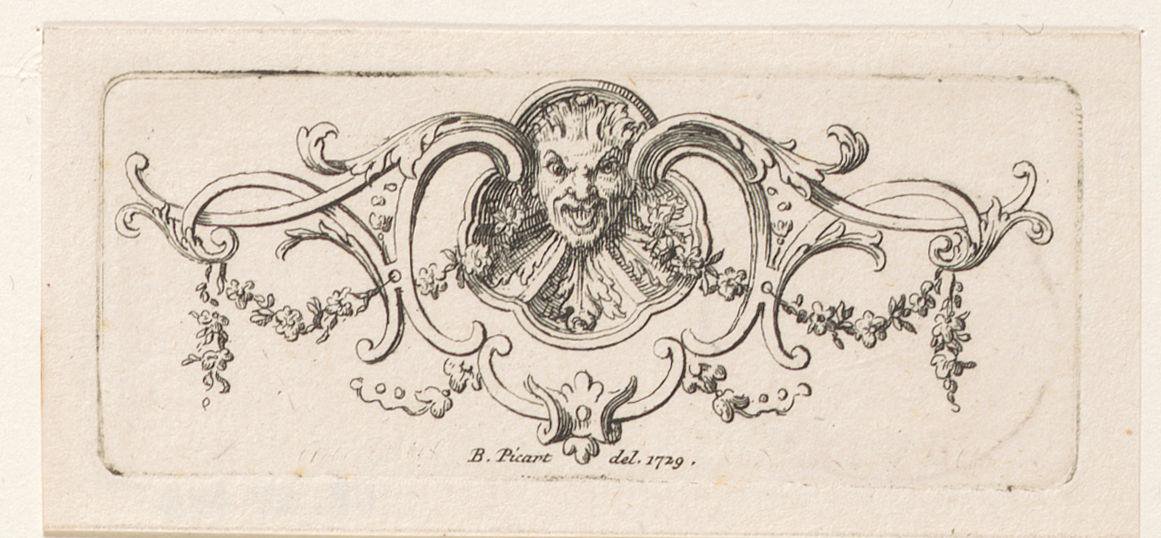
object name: print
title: Ornament met gezicht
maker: bernard picart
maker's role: draughtsman, print maker, publisher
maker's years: 1673-1733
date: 1729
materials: paper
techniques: engraving, etching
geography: amsterdam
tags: ornaments ~ art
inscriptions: collector's mark: Lugt 240